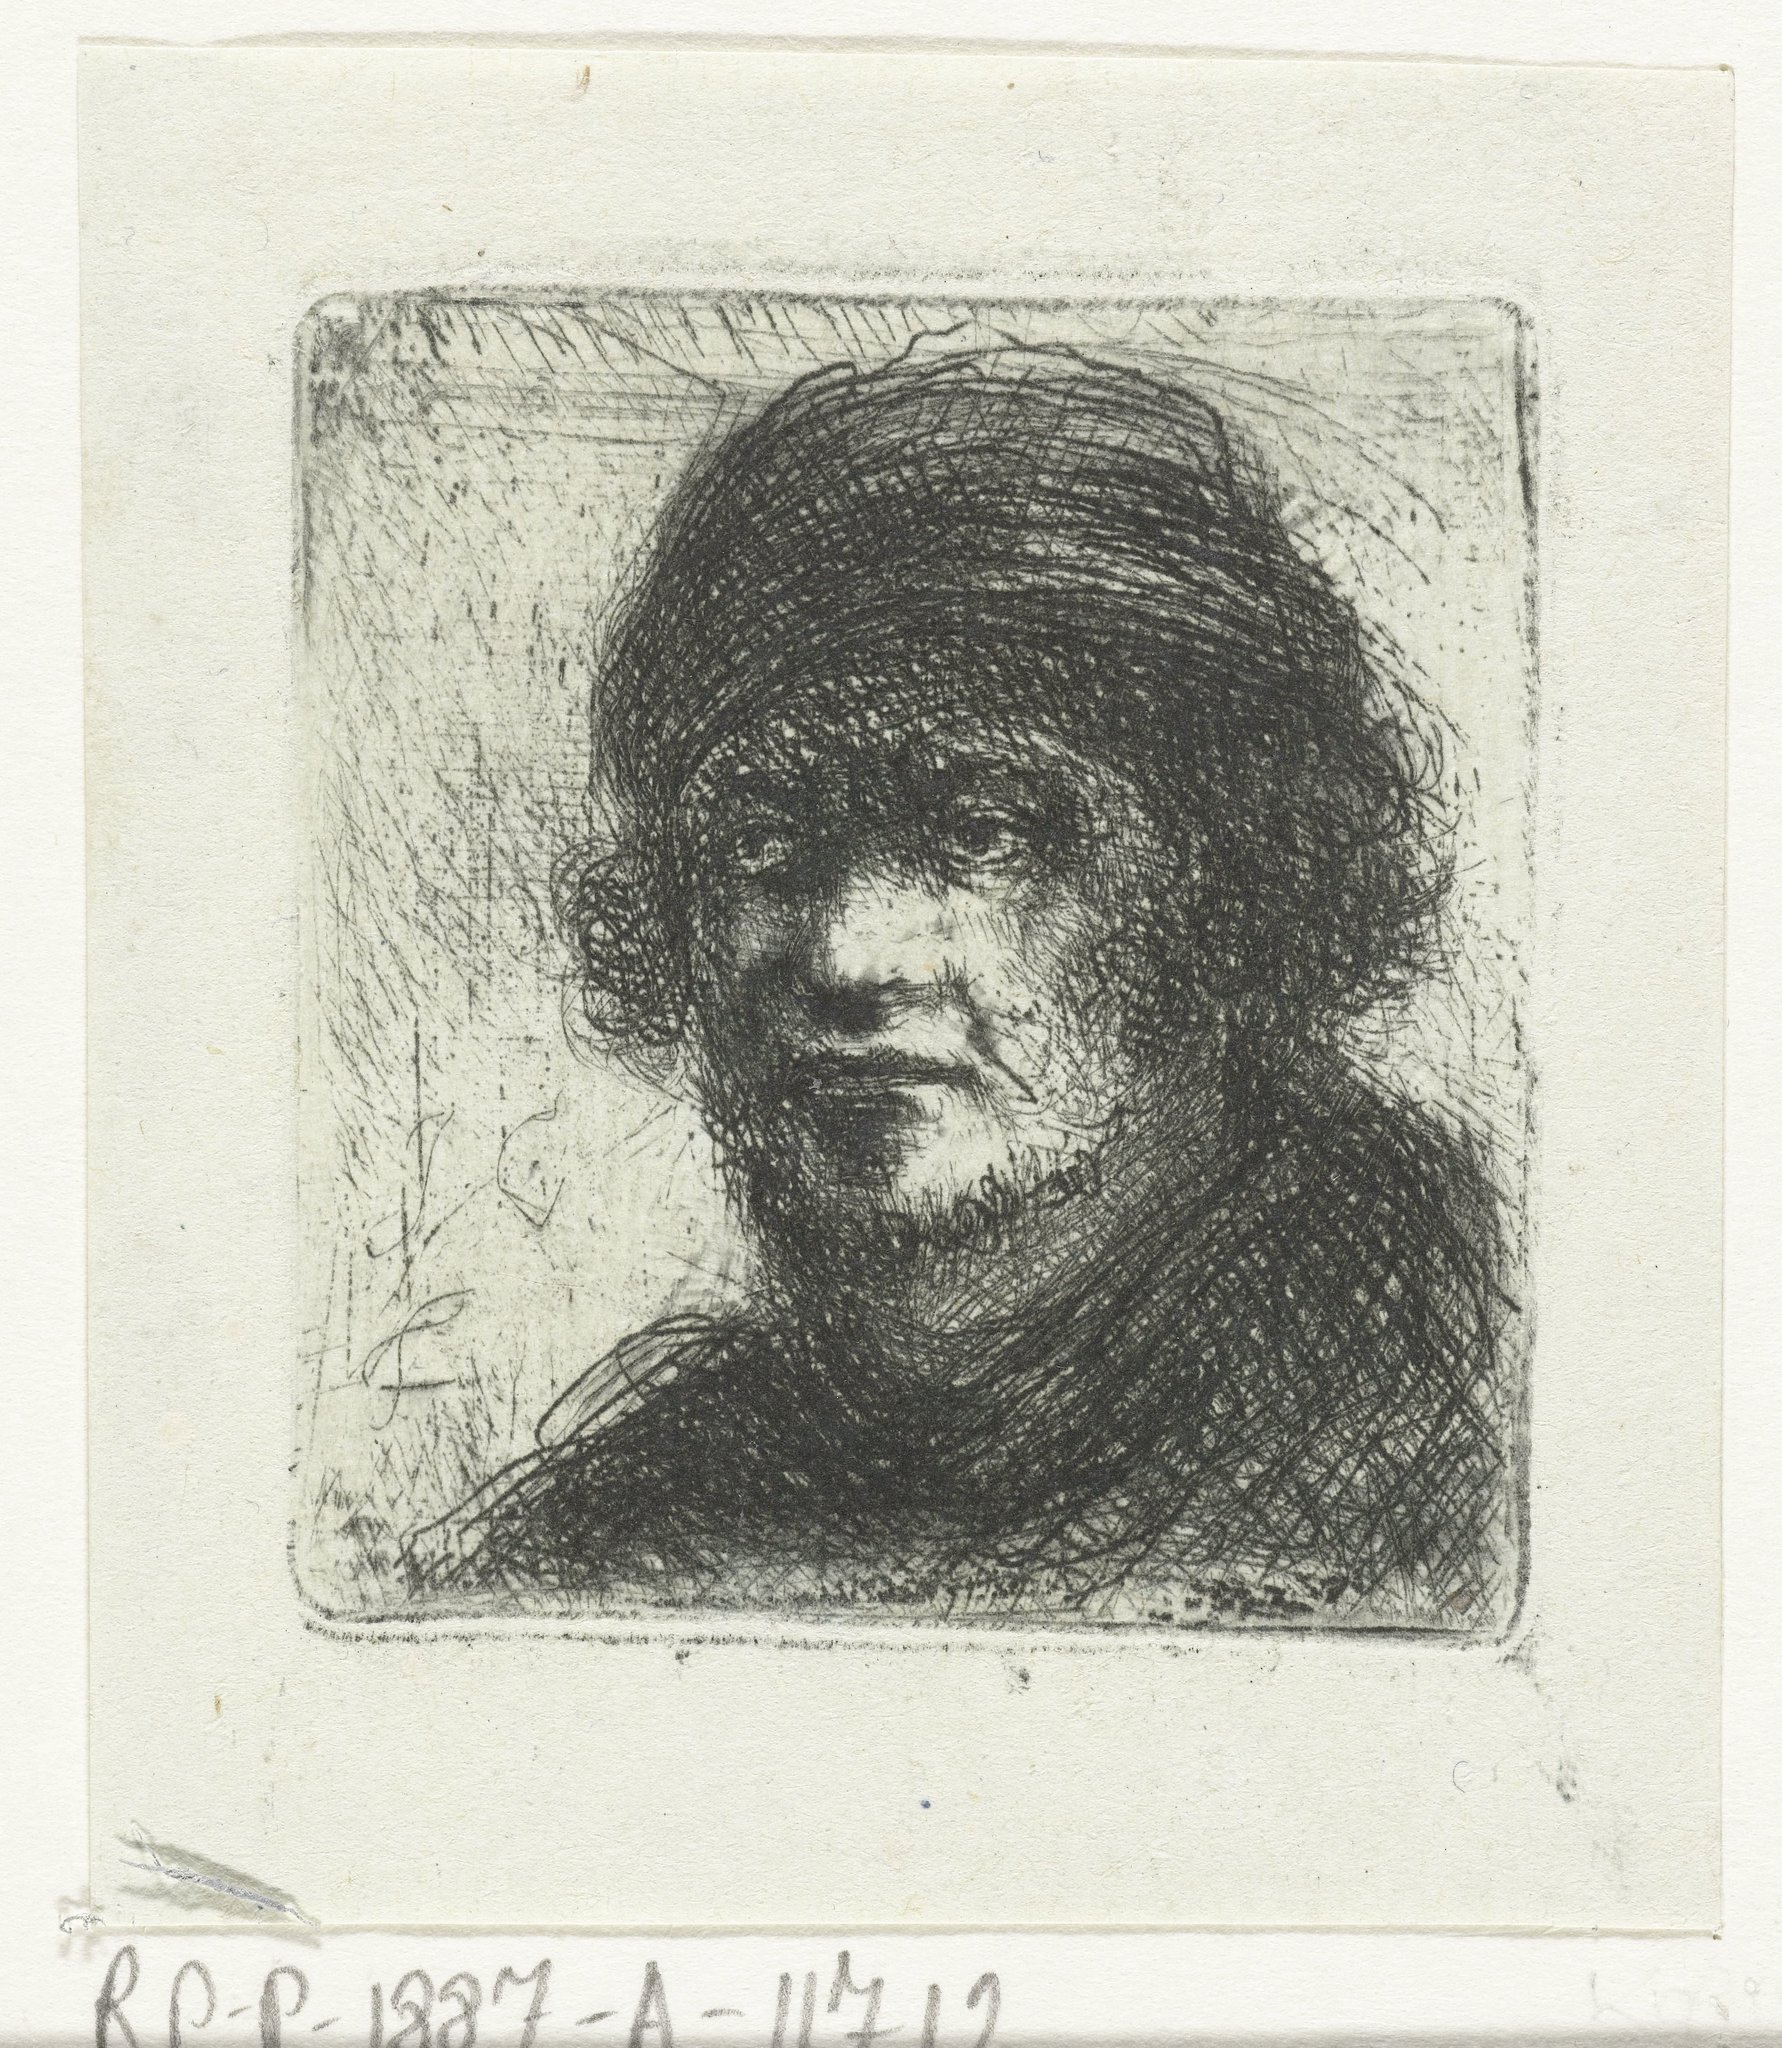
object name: print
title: Volwassen man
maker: jan chalon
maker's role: print maker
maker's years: 1738-1795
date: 1748-1795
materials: paper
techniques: drypoint, etching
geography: northern netherlands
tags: head-gear: cap (+ men's clothes), morphology of human expression (+ adult male (human being))